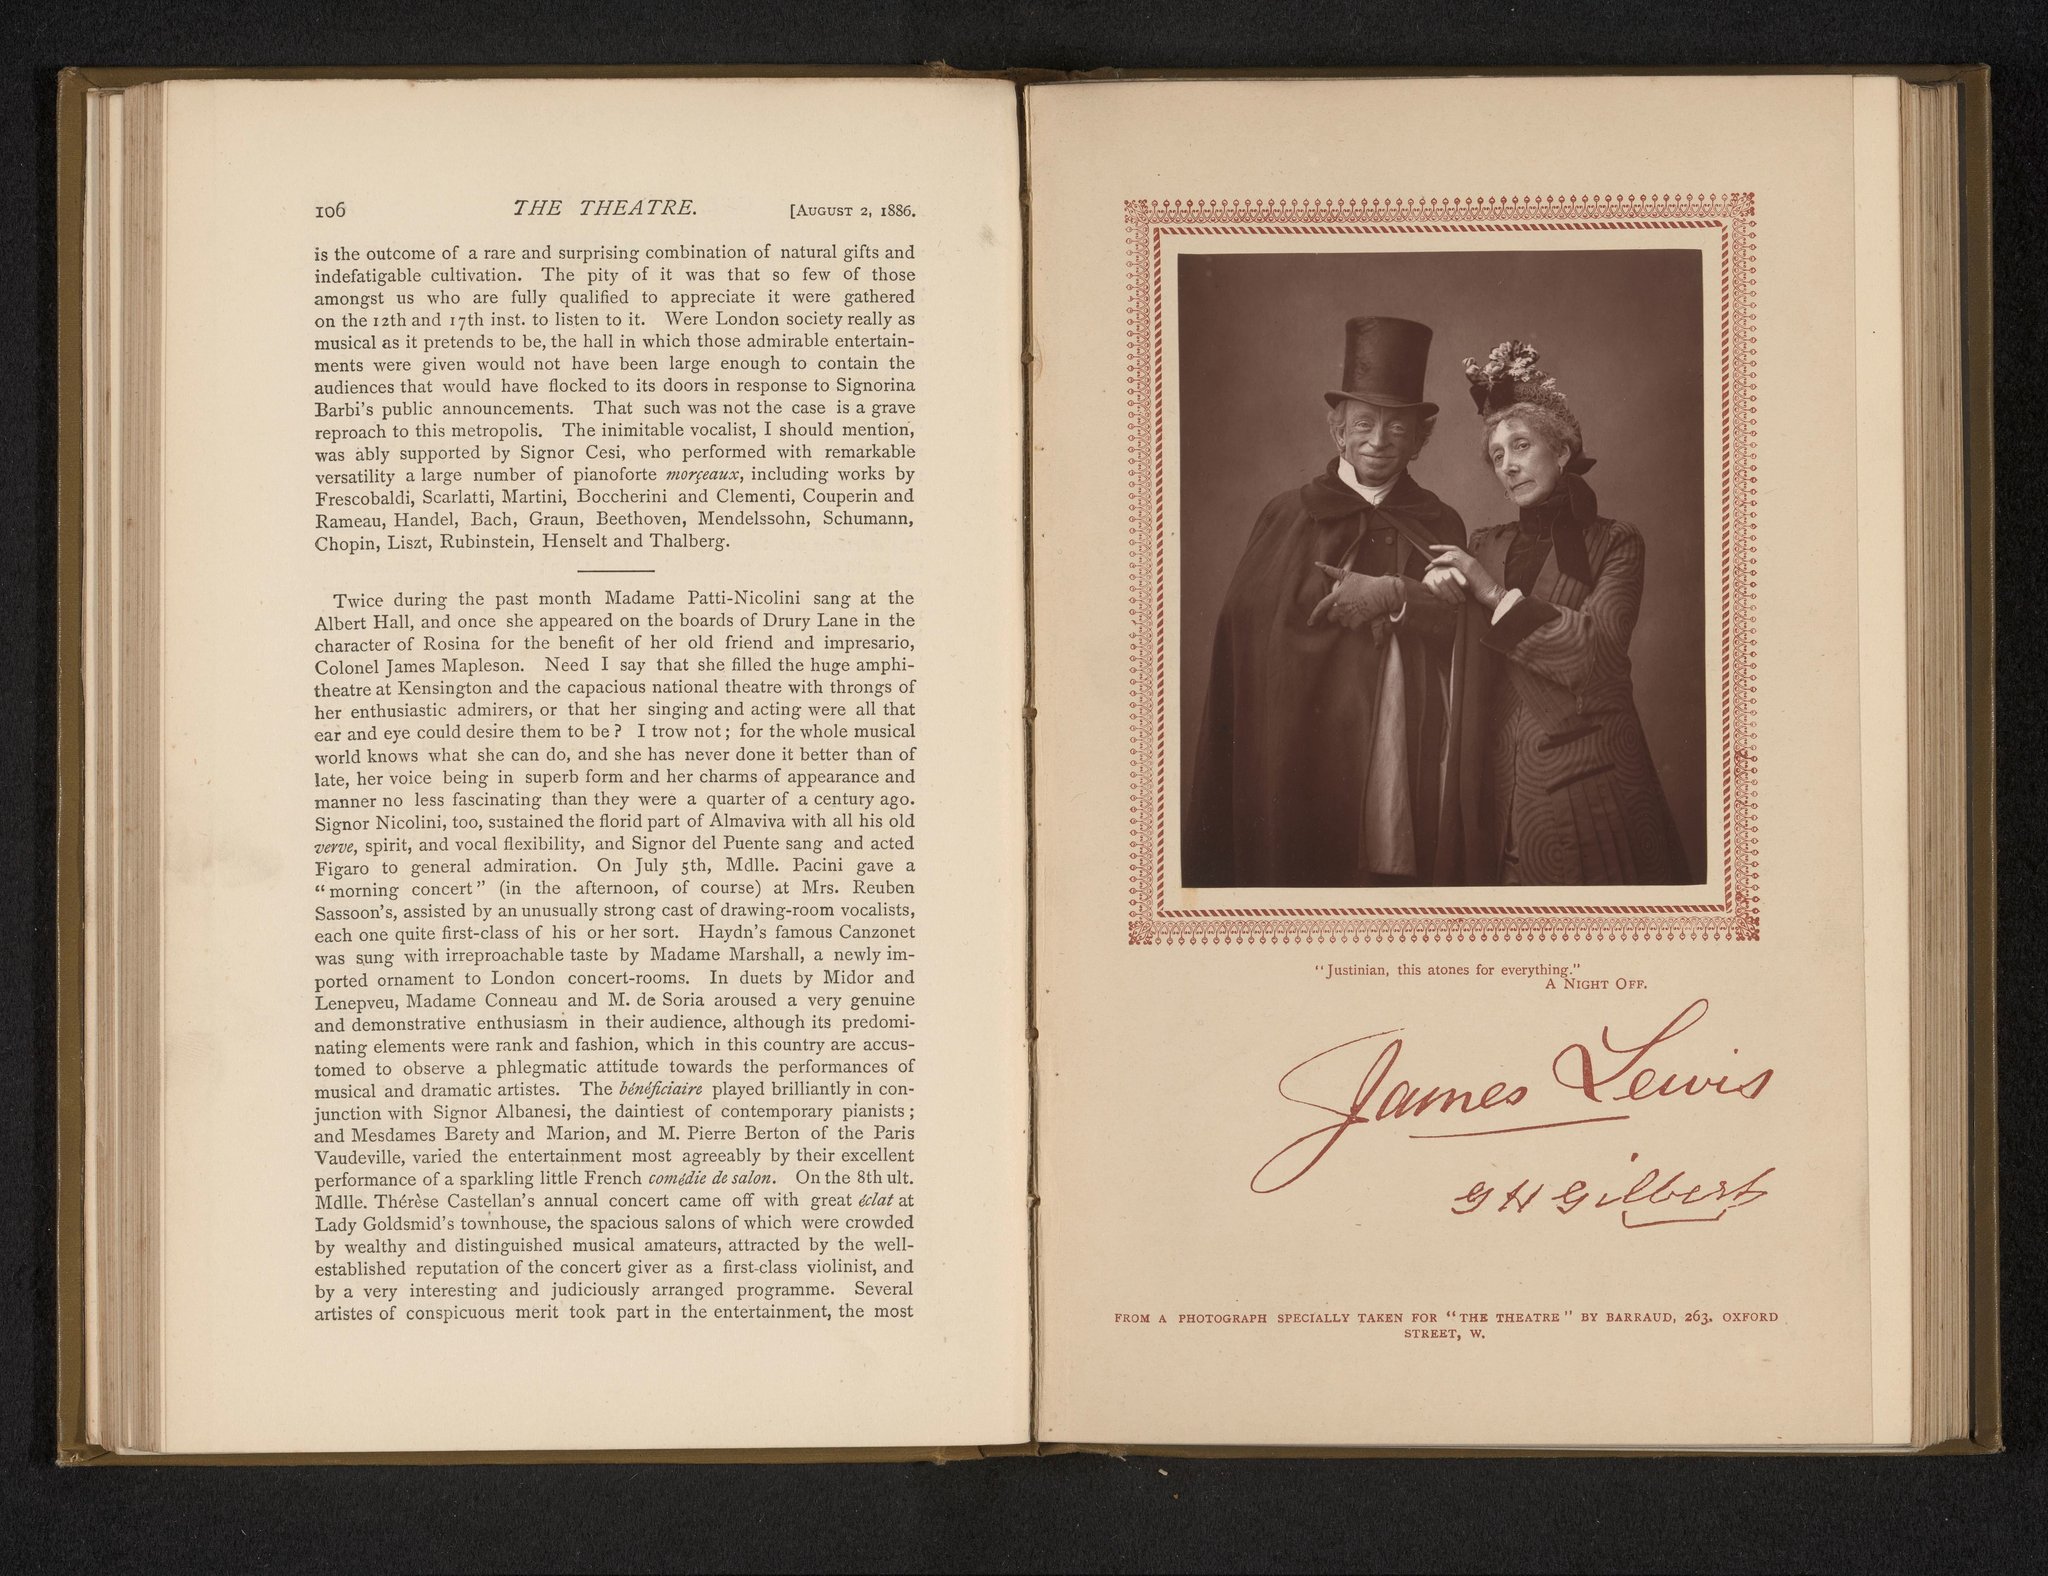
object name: page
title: Portret van James Lewis en Mrs. Gilbert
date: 1881-1886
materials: paper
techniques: woodburytype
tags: adult woman, adult man, historical persons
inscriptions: signature: ‘James Lewis/ [...] Gilbert’, inscription: ‘'Justinian, this atones for everything.'/ A Night Off’